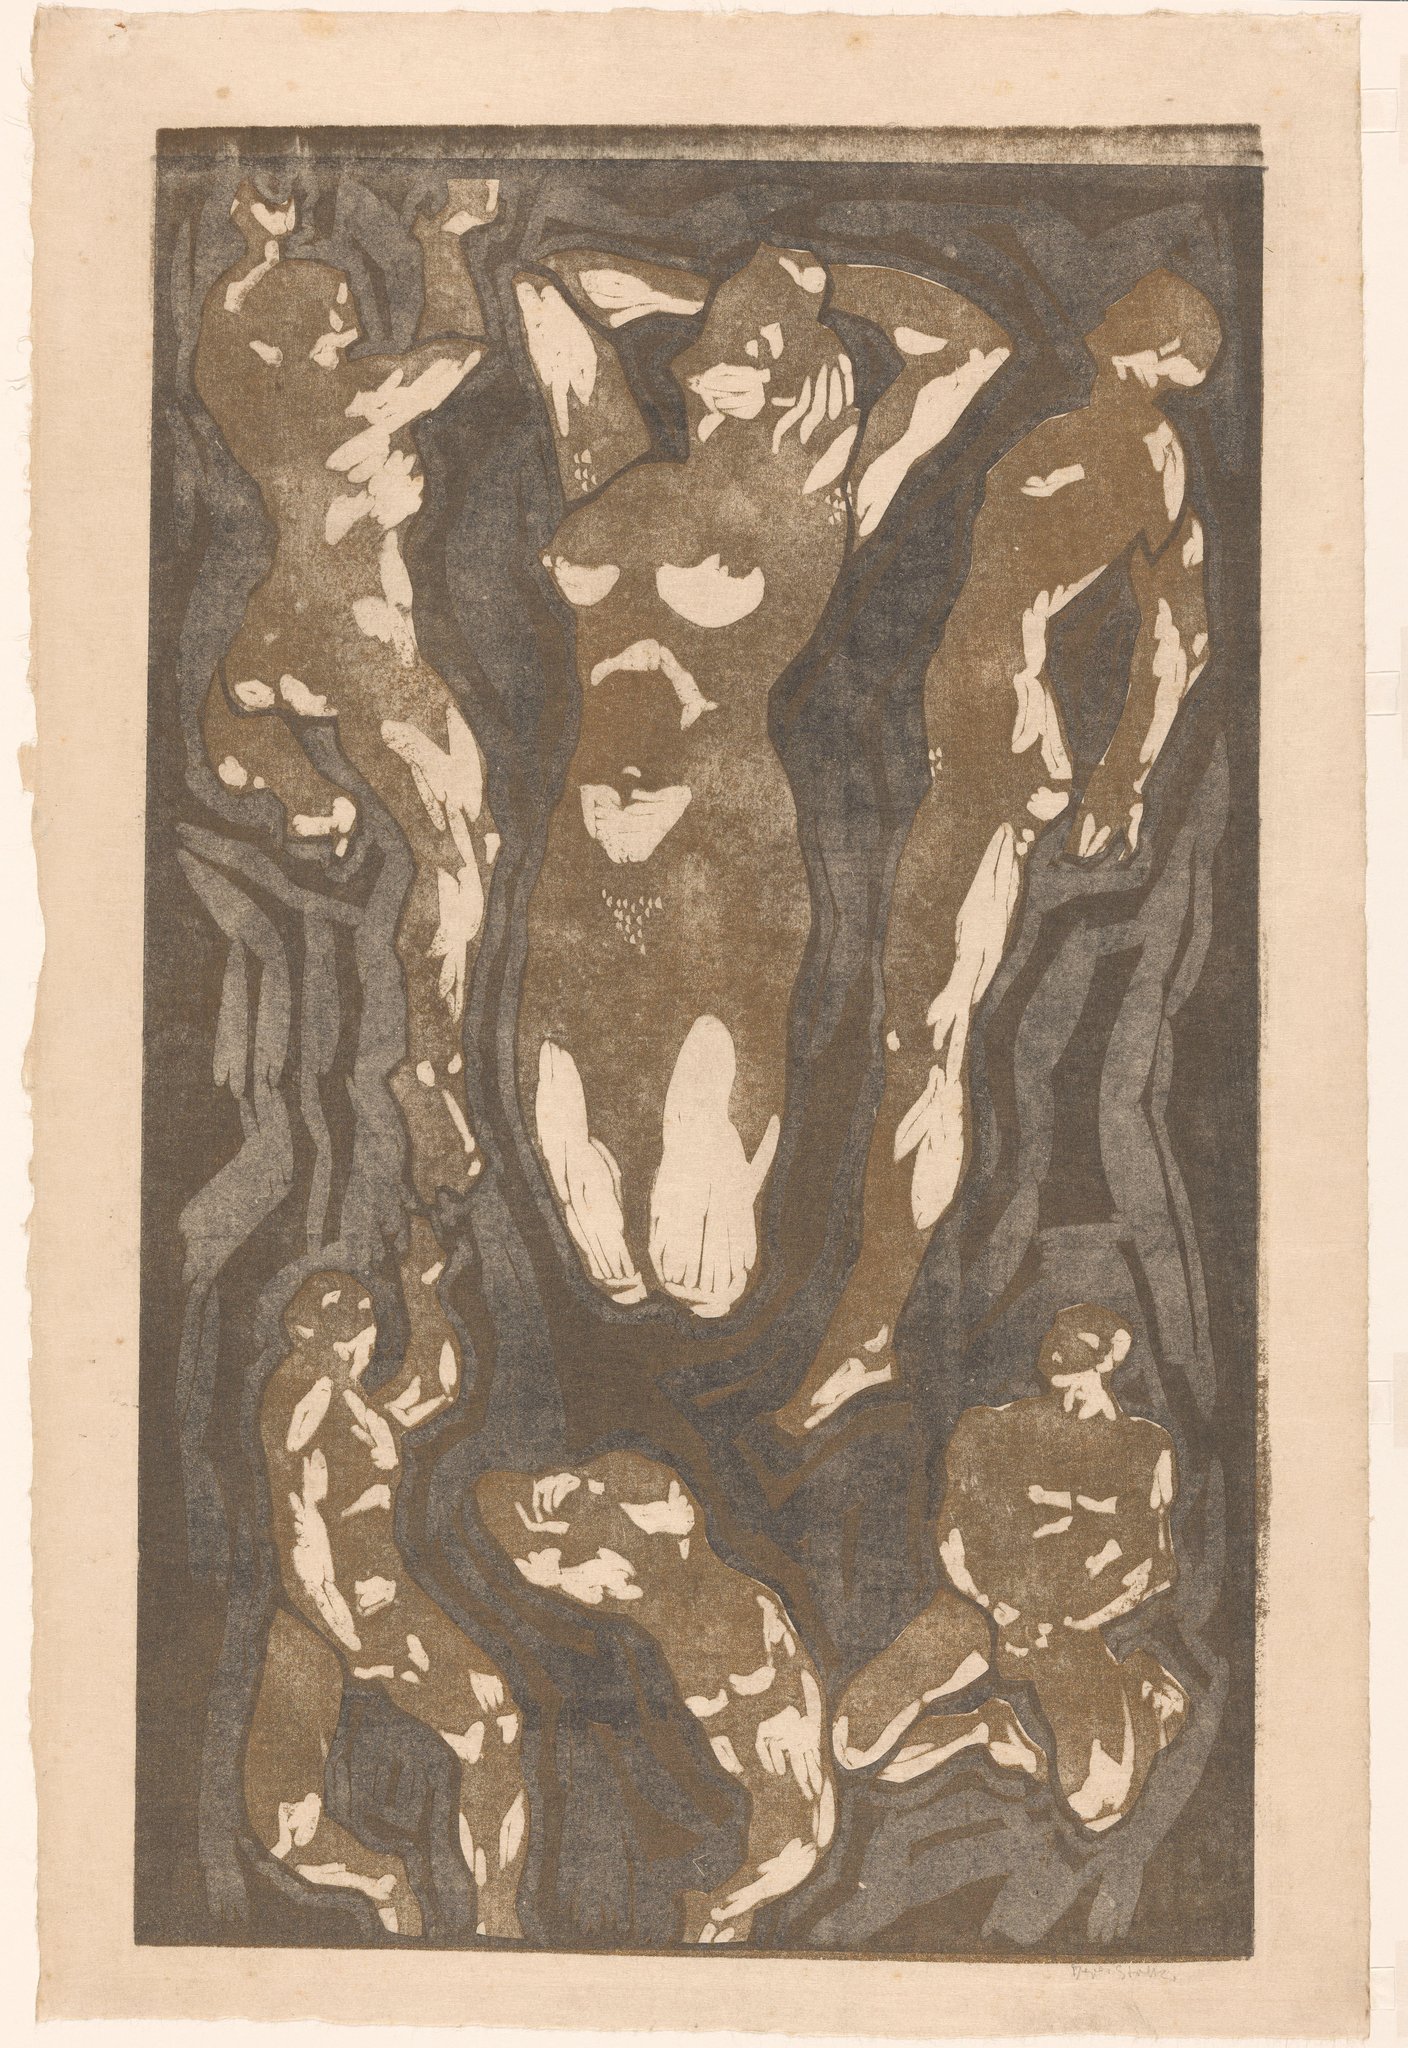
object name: print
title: Compositie met zes menselijke figuren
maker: reijer stolk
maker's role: draughtsman, print maker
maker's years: 1896-1945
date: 1906-1945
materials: paper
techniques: woodcut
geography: netherlands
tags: fate, doom, postures of the human figure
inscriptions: collector's mark: Lugt 2228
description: In het midden een naakte vrouw met haar armen boven haar hoofd geheven.